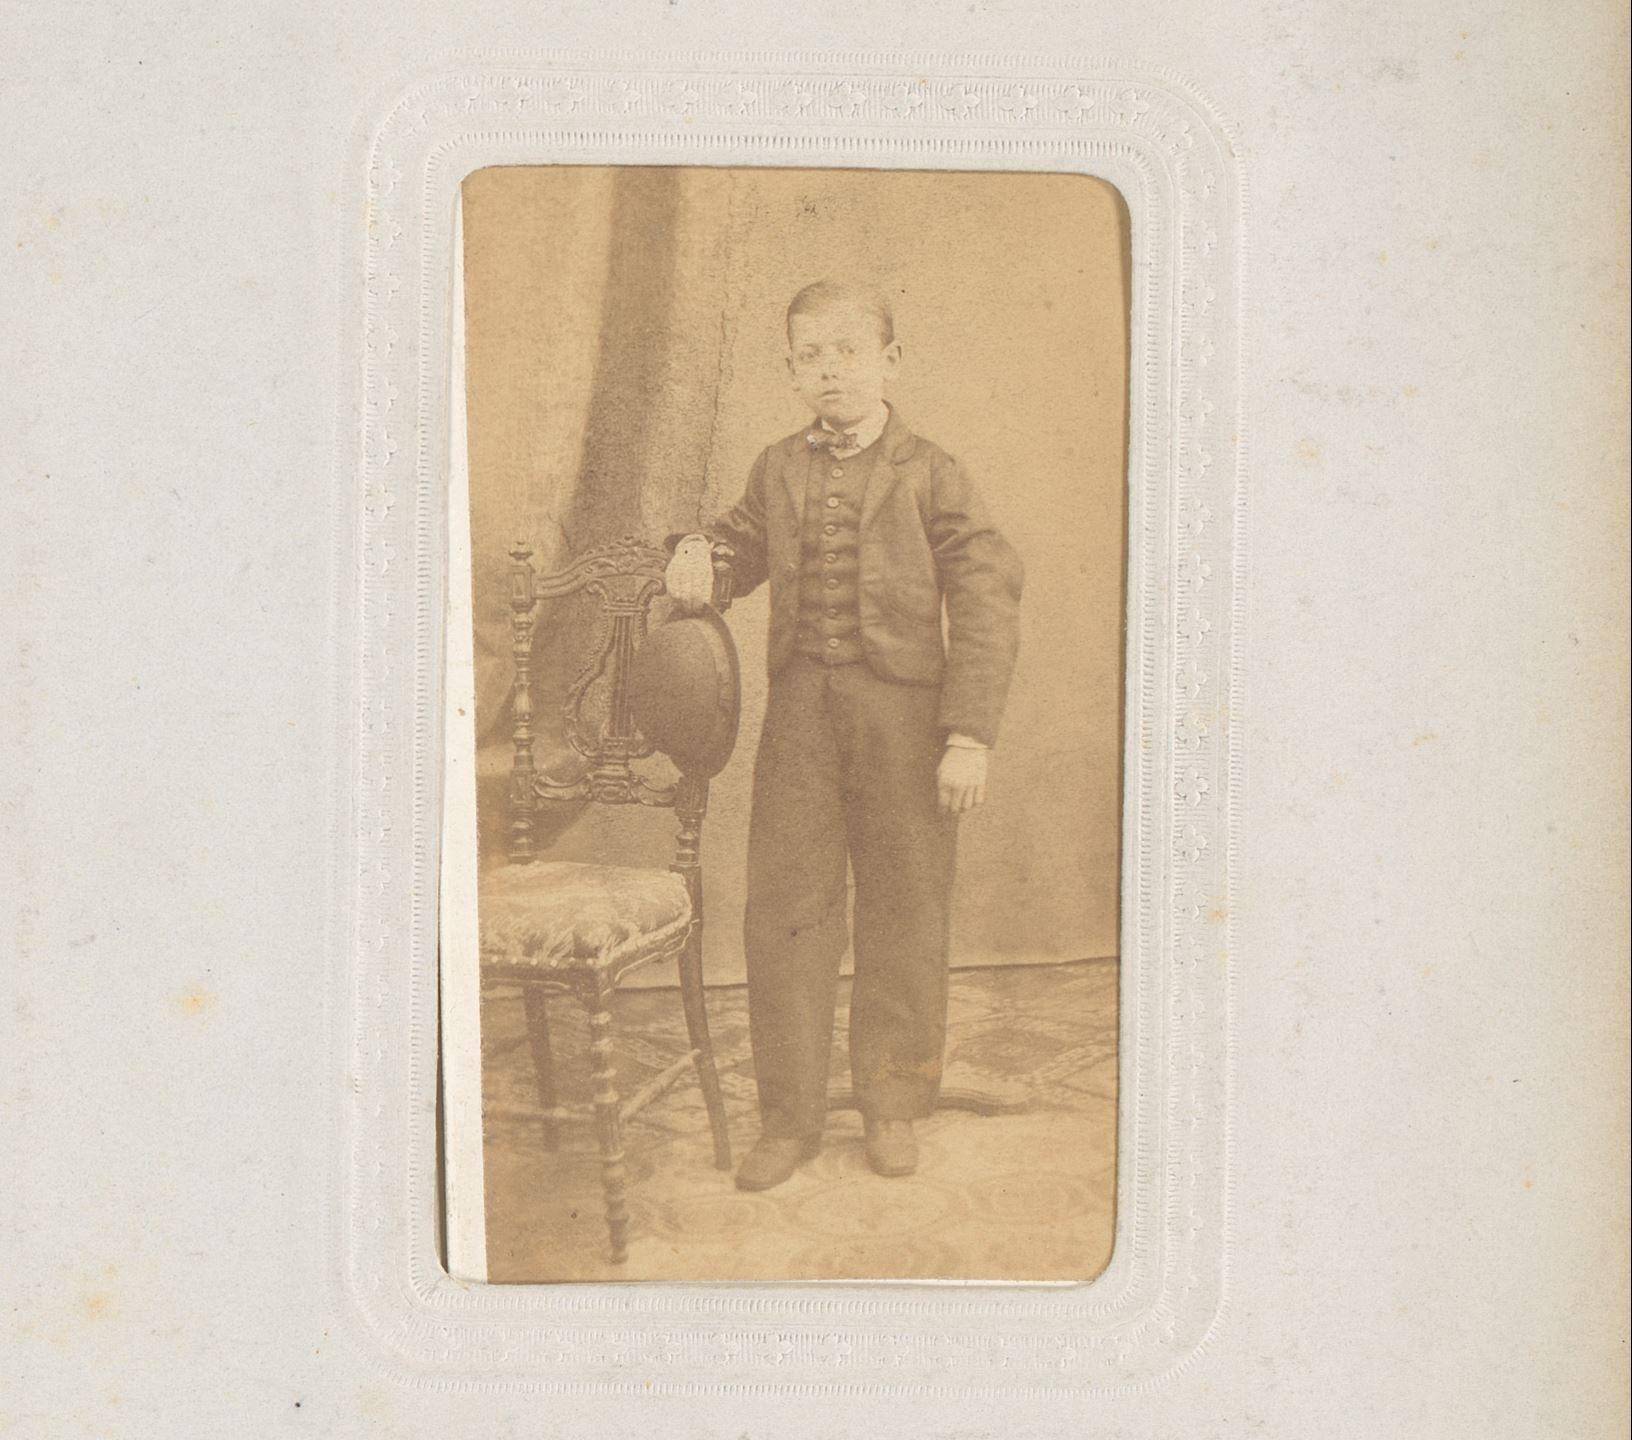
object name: photograph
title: Portret van een jongen, staand bij een stoel met hoed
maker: Anonymous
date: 1860-1890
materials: cardboard, photographic support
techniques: albumen print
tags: boy (child between toddler and youth), head-gear: hat